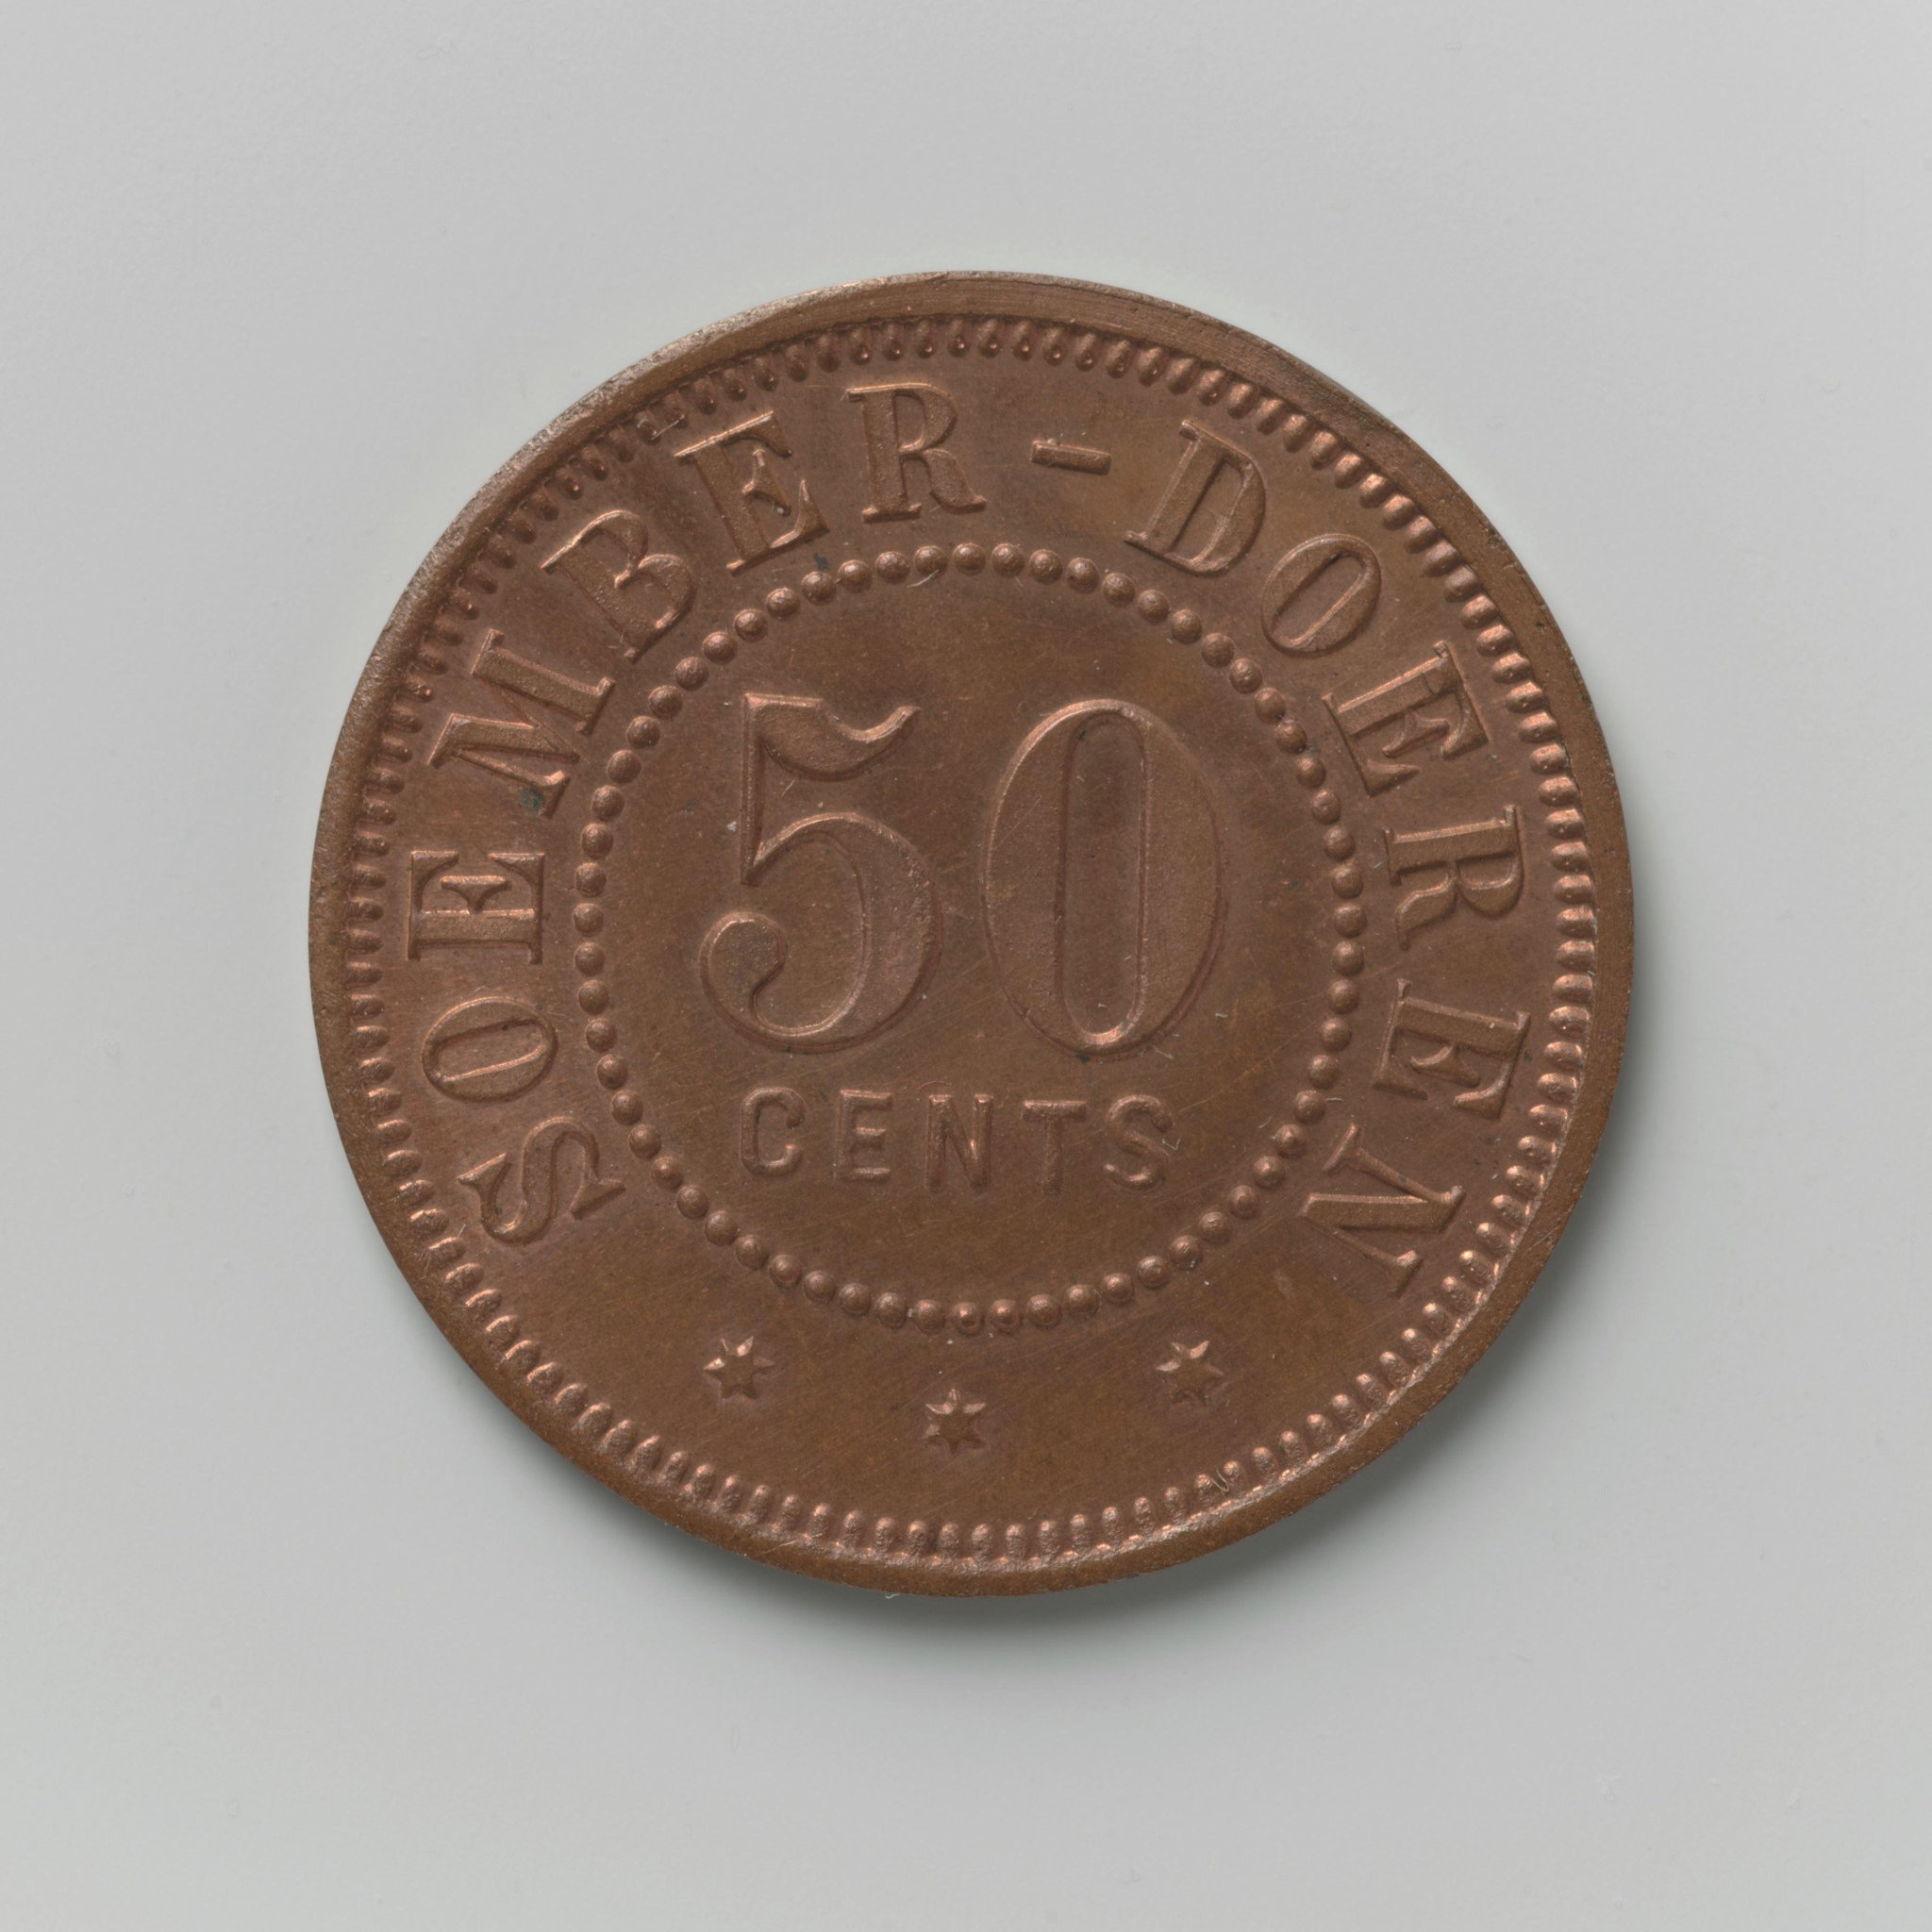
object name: vijftig cent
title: Plantage Soember Boeren, 50 cents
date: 1875-1925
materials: copper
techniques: striking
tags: plantage soember-doeren, passoeroean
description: Koperen partuculiere munt. Plantage-geld. Voorzijde: in twee regels waarde-aanduiding. In omschrift aanduiding van de plantage. Keerzijde: in twee regels waarde-aanduiding. Gladde rand.